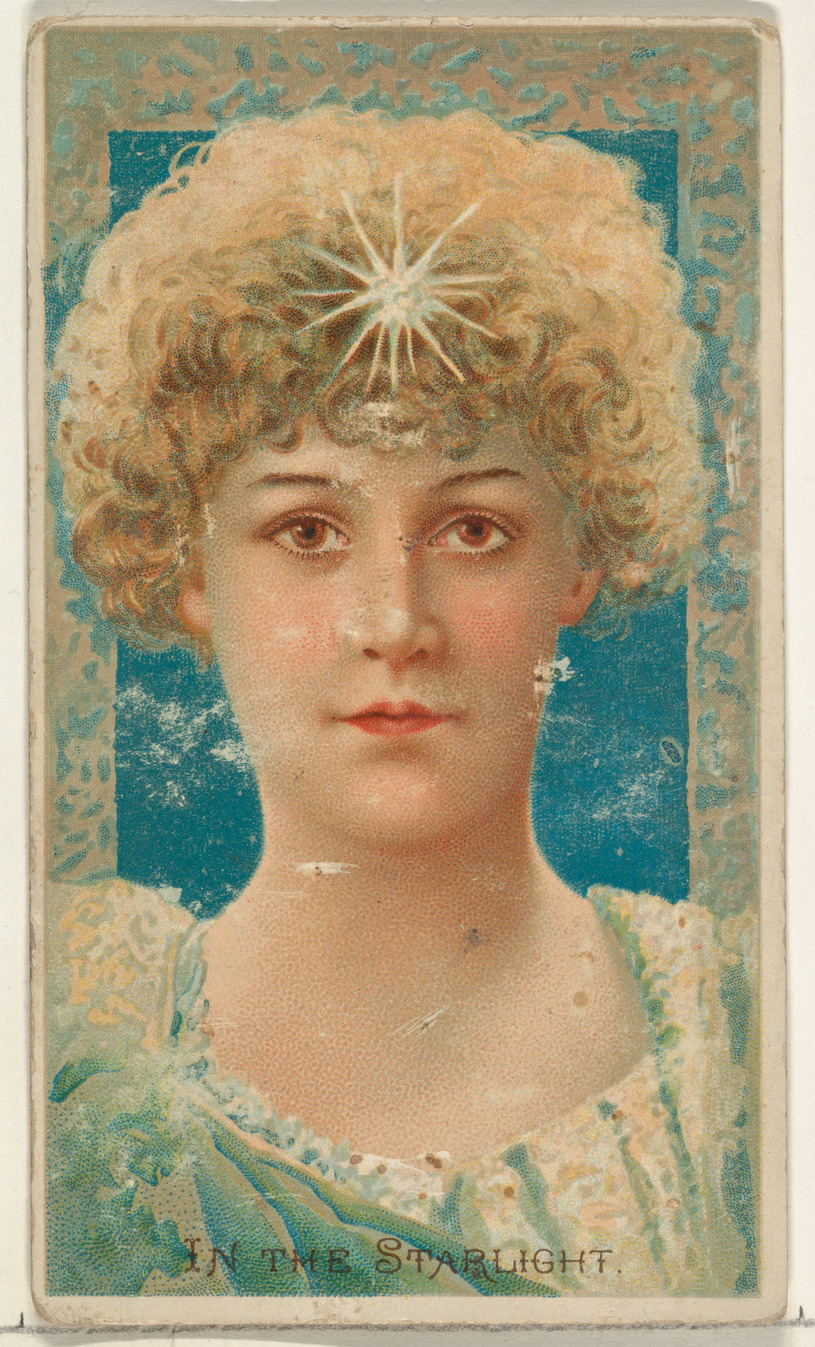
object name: print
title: In the Starlight, from the Illustrated Songs series (N116) issued by W. Duke, Sons & Co. to promote Honest Long Cut Tobacco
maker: w. duke, sons & co.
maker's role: publisher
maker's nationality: american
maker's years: 1870-1920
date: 1893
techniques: color lithograph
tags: women